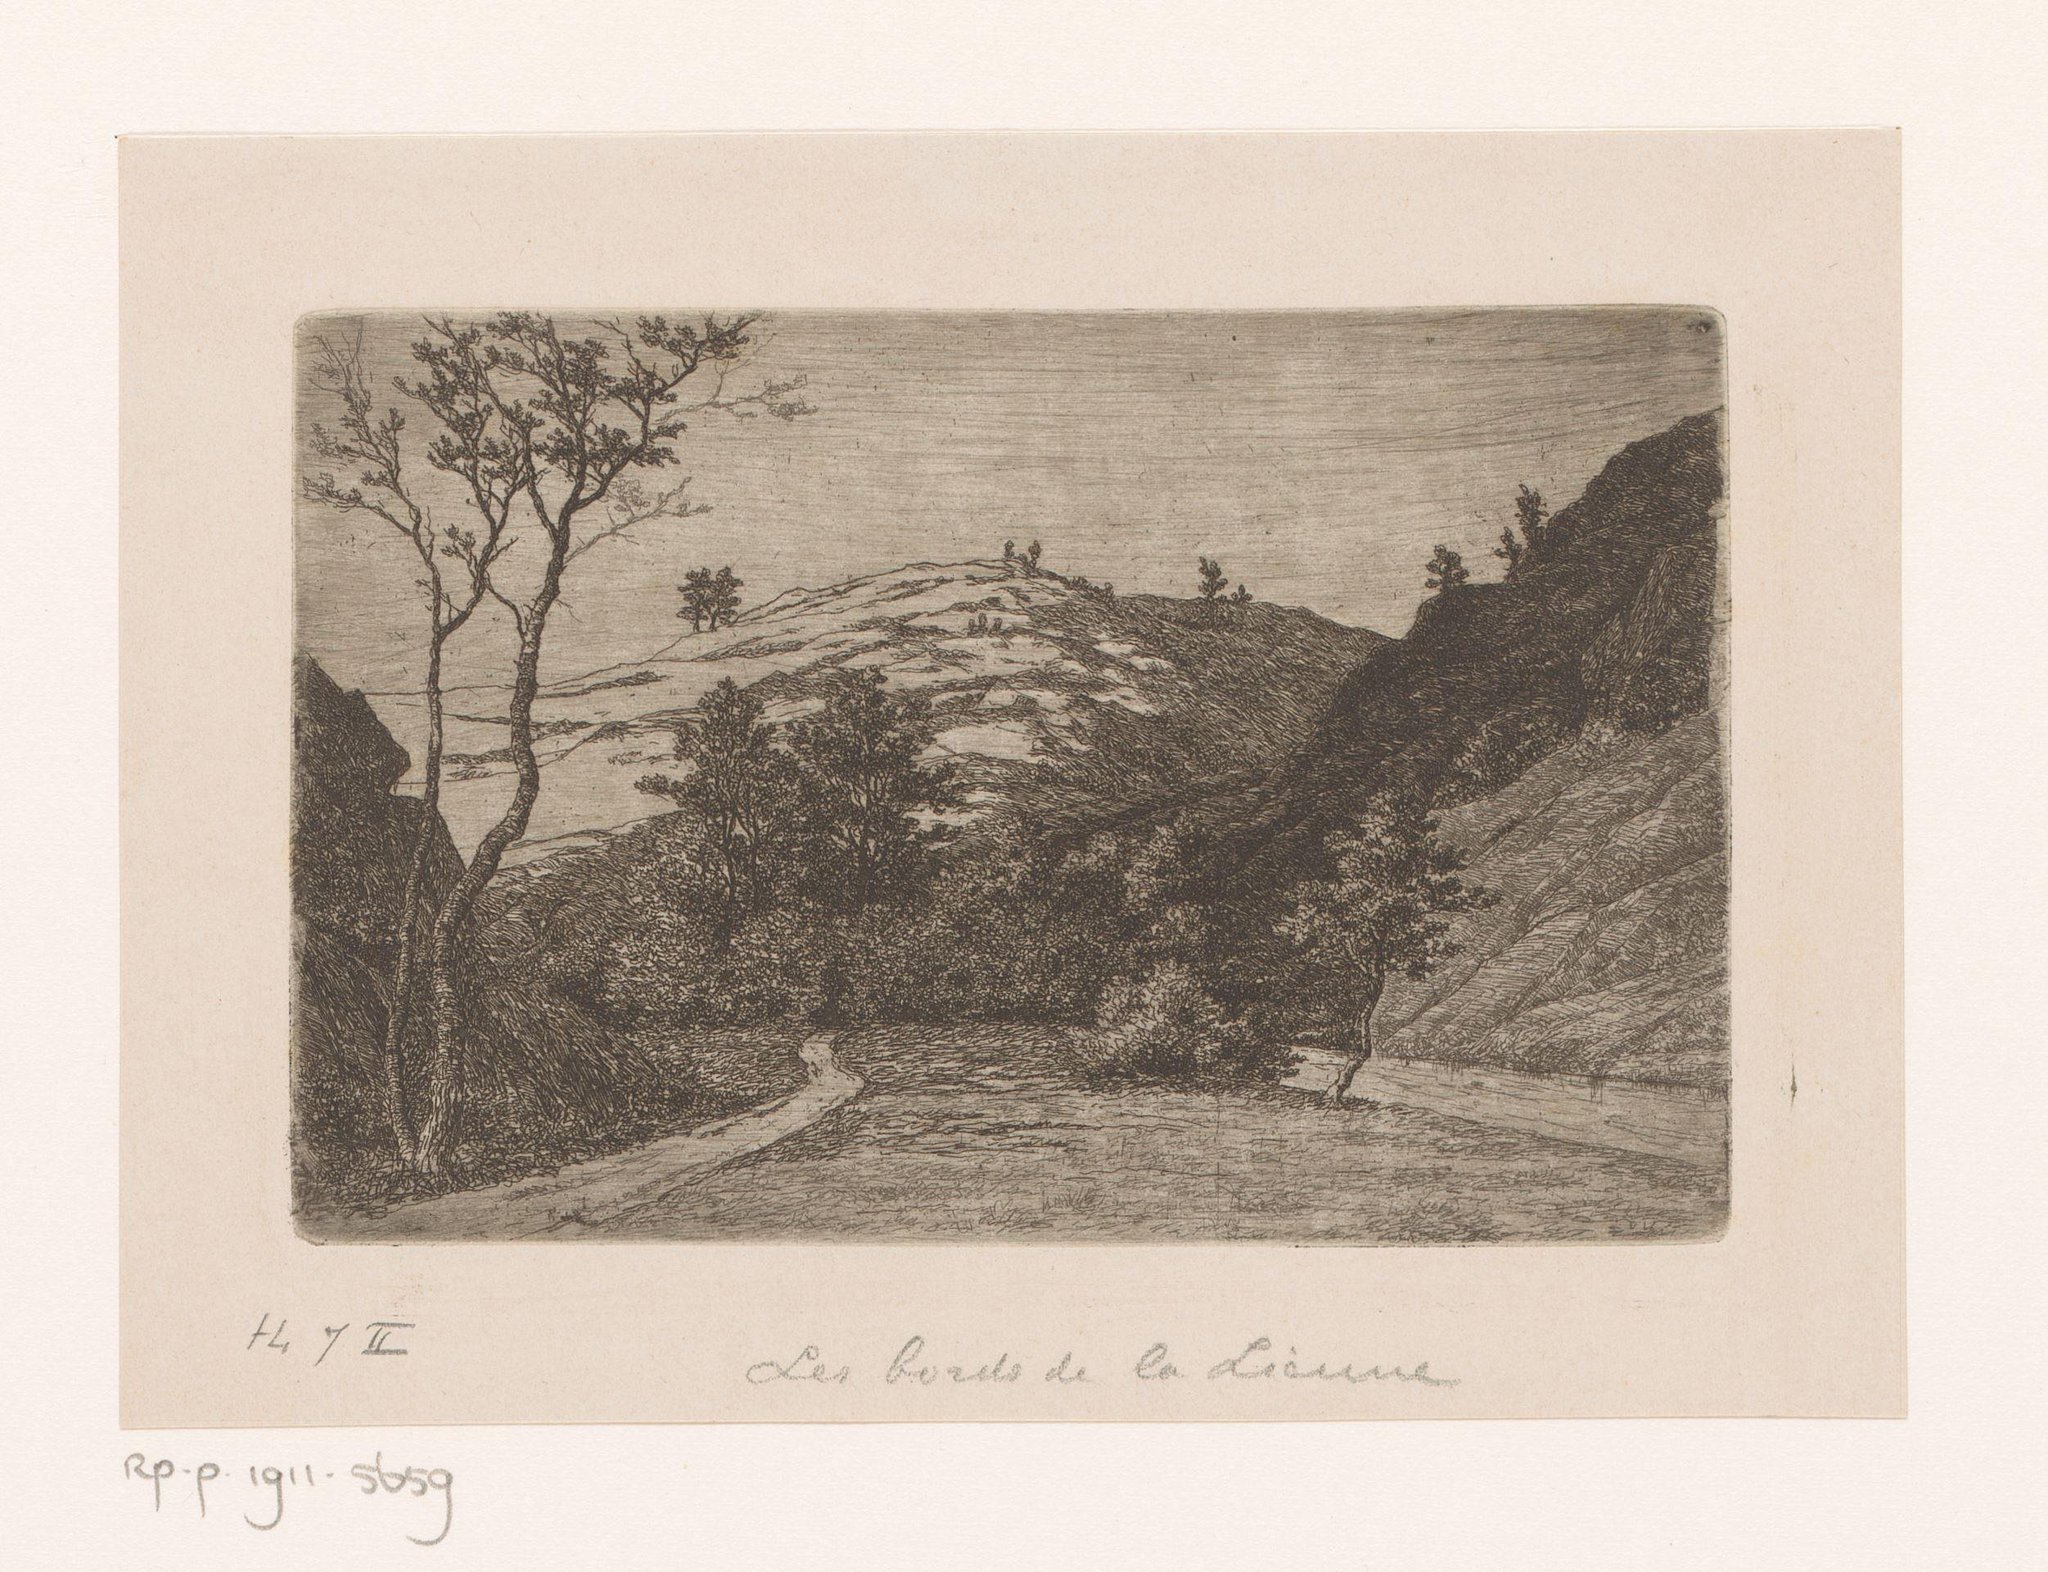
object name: print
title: Oevers van de rivier Lienne bij Rahier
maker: jean pierre françois lamorinière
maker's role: print maker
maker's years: 1828-1911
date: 1838-1911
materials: paper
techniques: drypoint, etching, intaglio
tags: river, (high) hill, liège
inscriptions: collector's mark: Lugt 1485, collector's mark: Lugt 2228